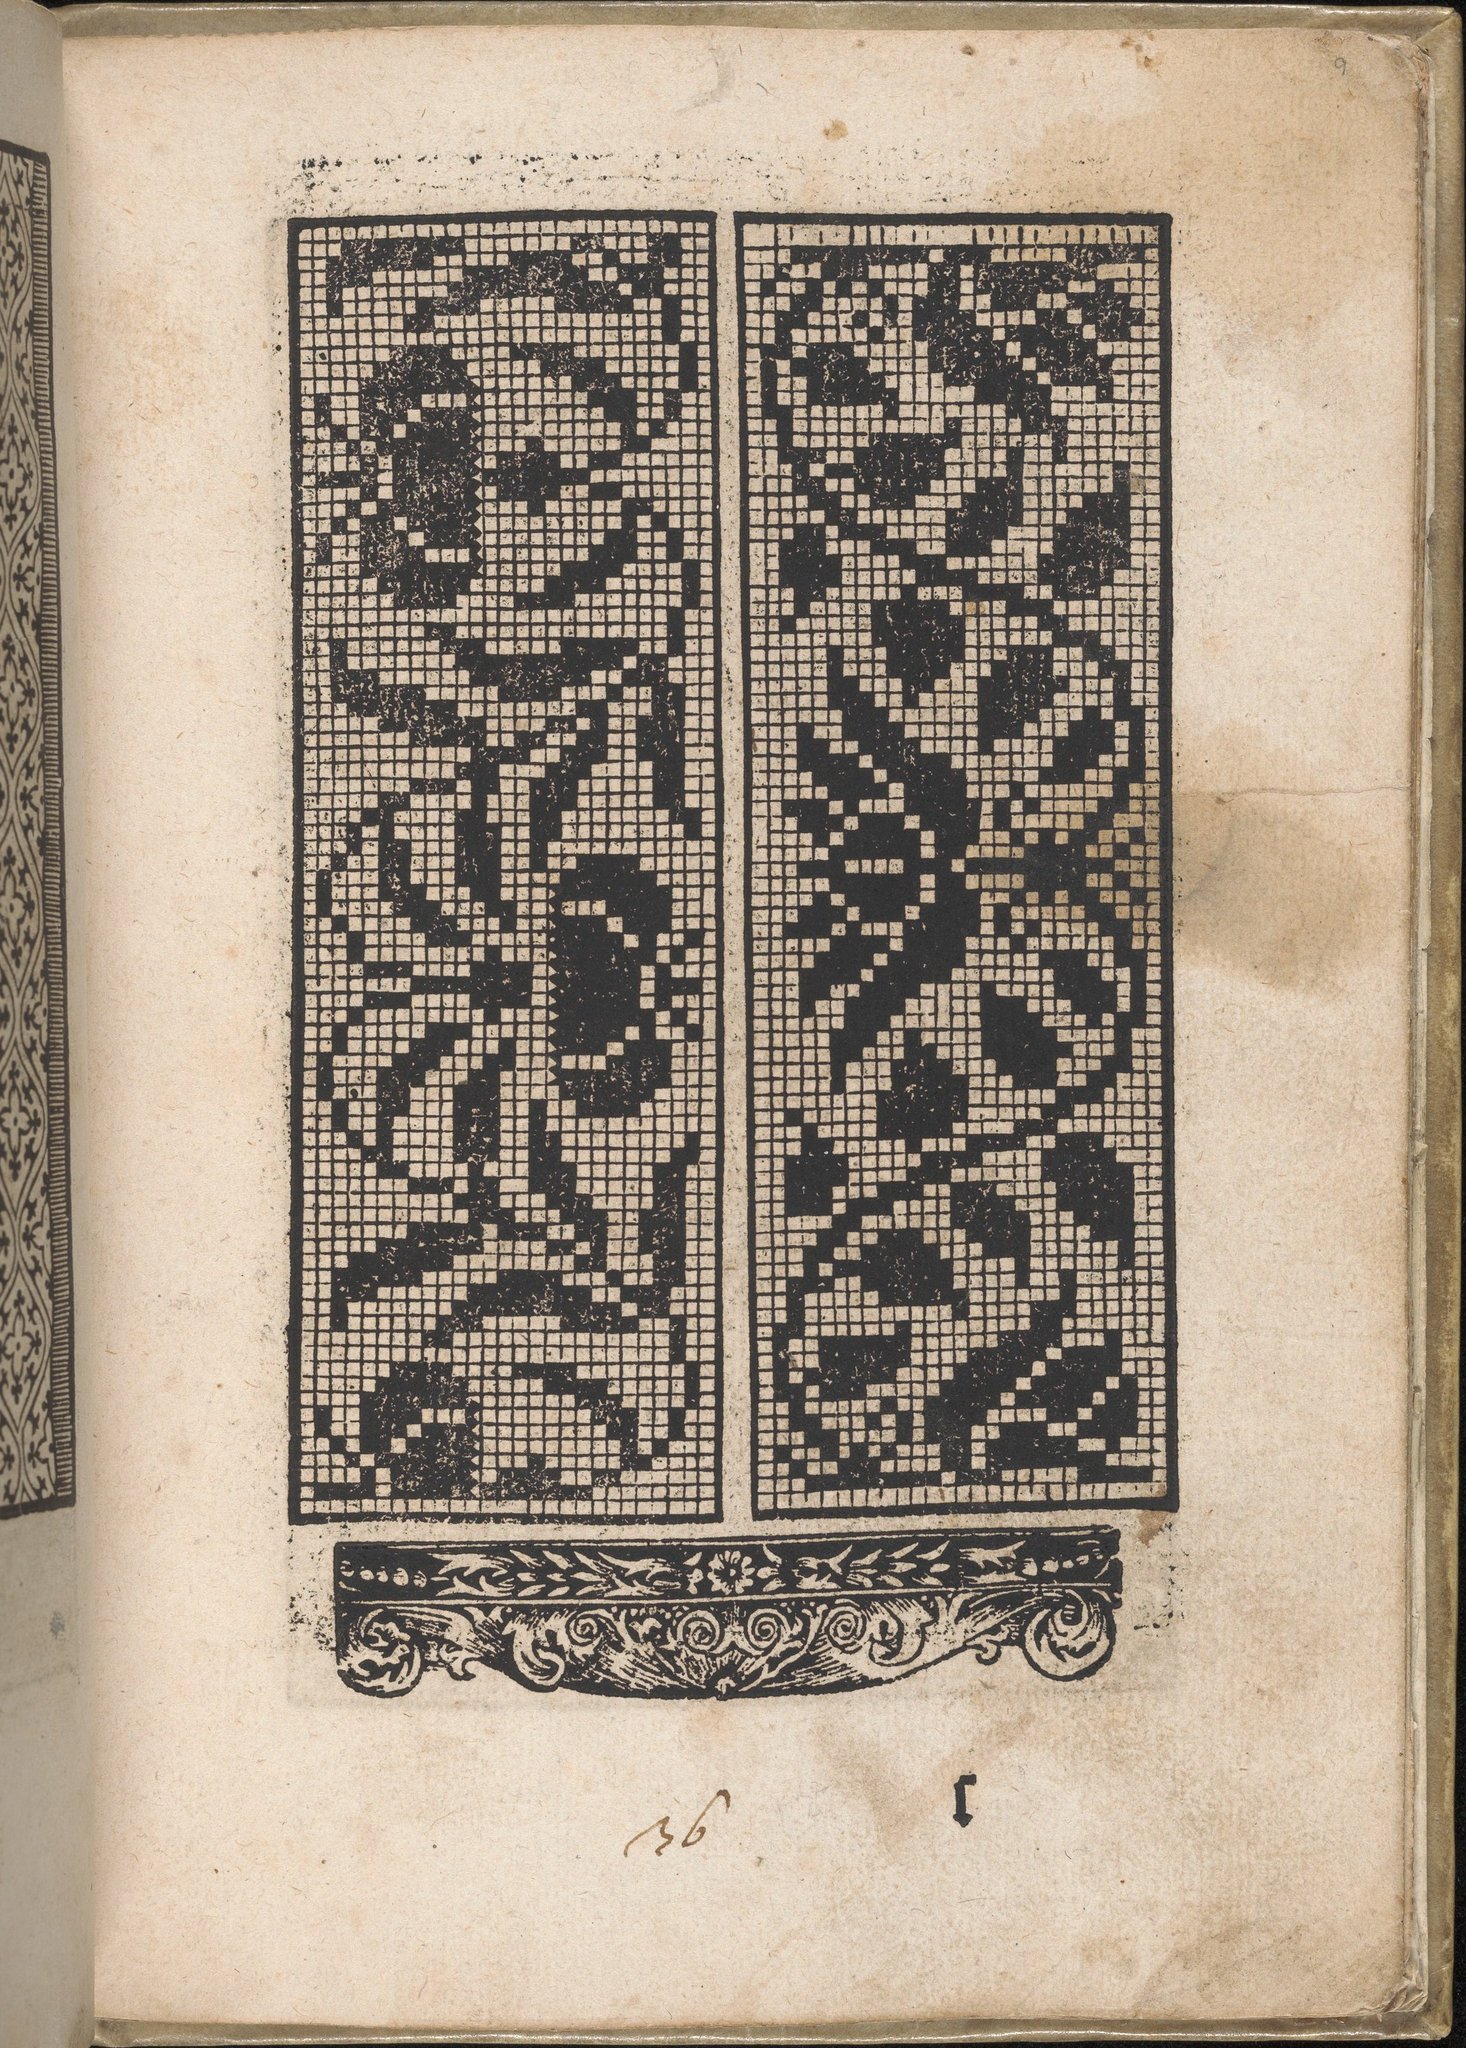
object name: book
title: Page 10r, from "Eyn New Kunstlichboich"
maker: peter quentel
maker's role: publisher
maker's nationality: german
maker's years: 1500-1550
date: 1529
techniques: woodcut